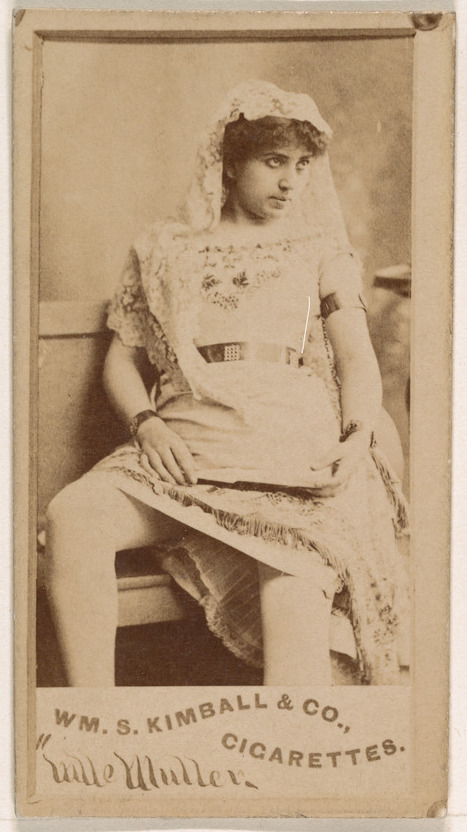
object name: photograph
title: Mlle. Muller, from the Actresses series (N203) issued by Wm. S. Kimball & Co.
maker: william s. kimball & company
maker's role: publisher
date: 1889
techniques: color lithograph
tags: portraits,women,actresses